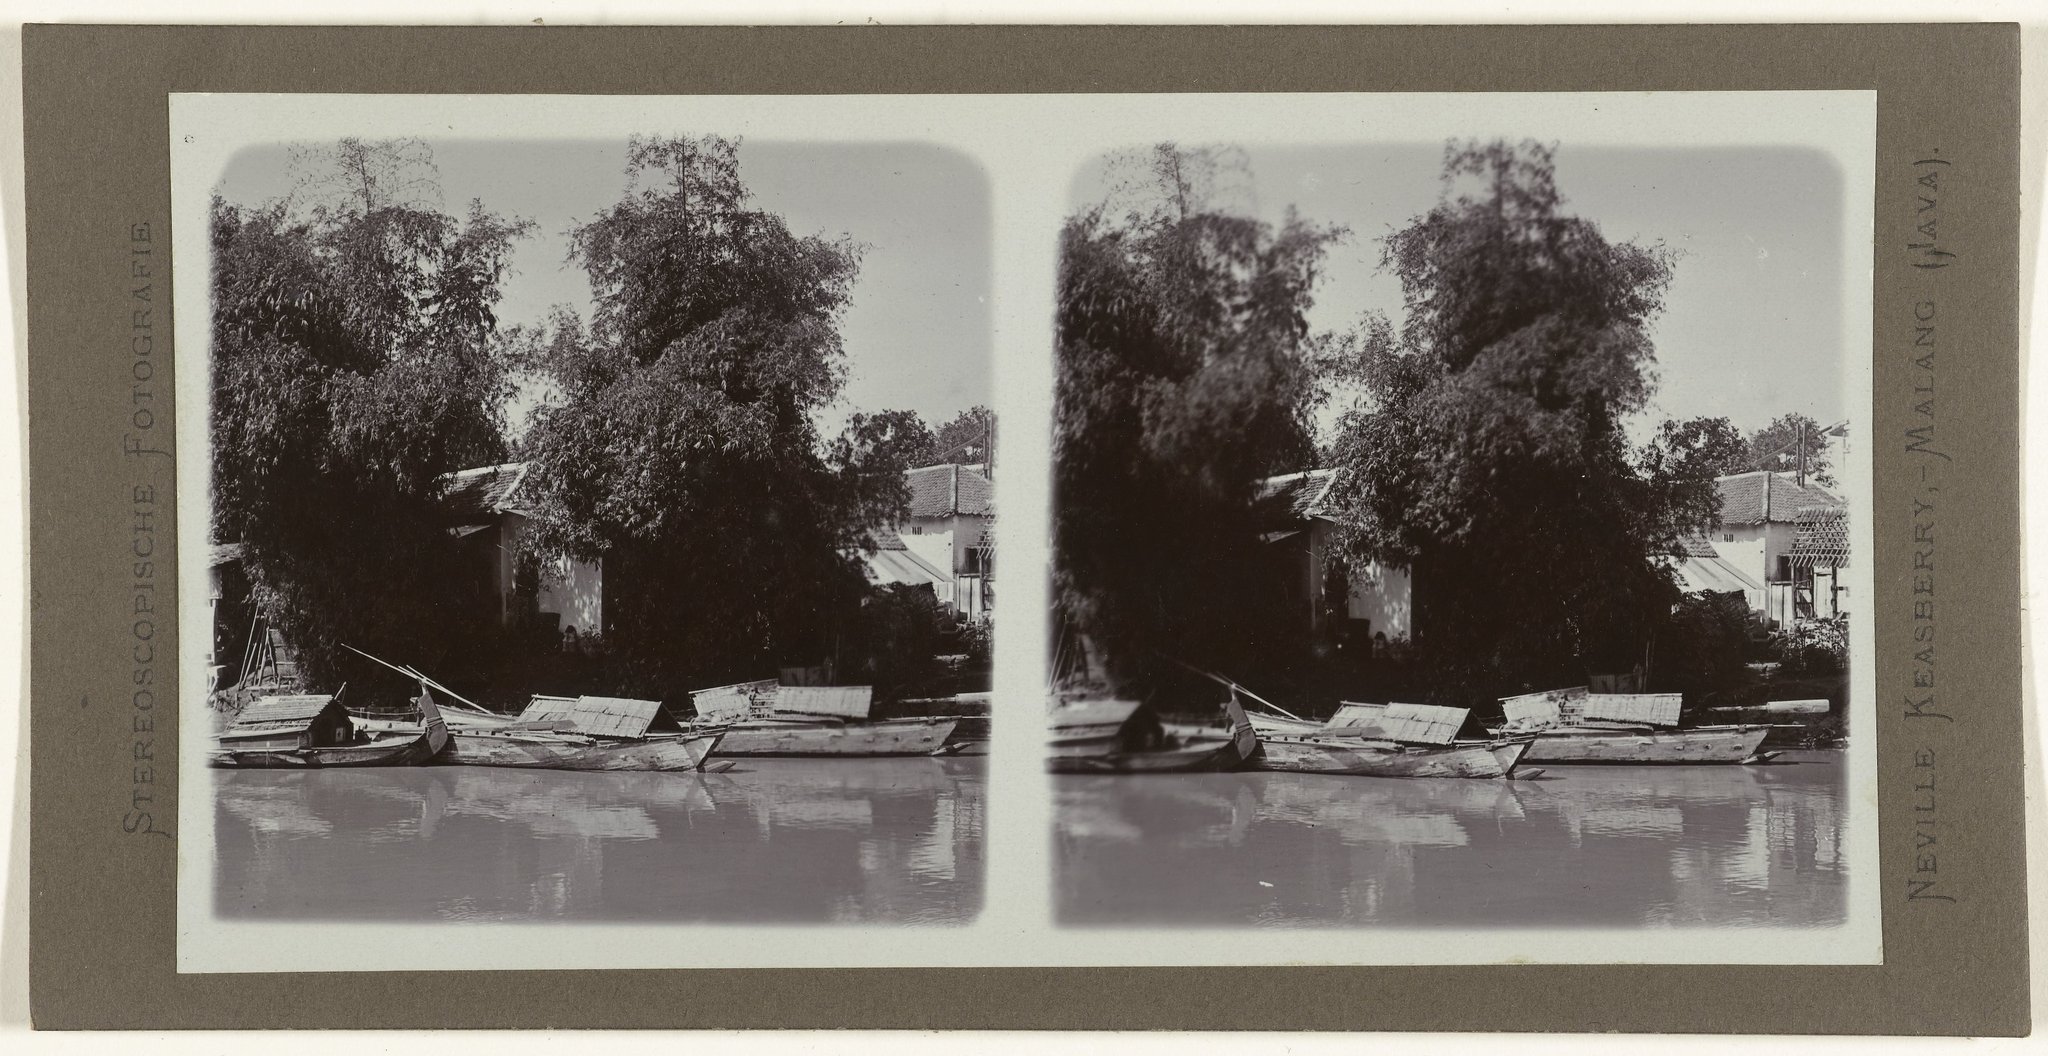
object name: photograph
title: Javaanse boten in de kalimas in Surabaya.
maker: neville keasberry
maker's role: fotograaf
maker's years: 1866-1944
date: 1900-1935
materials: cardboard, paper, photographic support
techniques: albumen print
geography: malang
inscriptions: inscription: ‘Stereoscopische Fotografie’, signature: ‘Neville Keasberry, Malang (Java)’